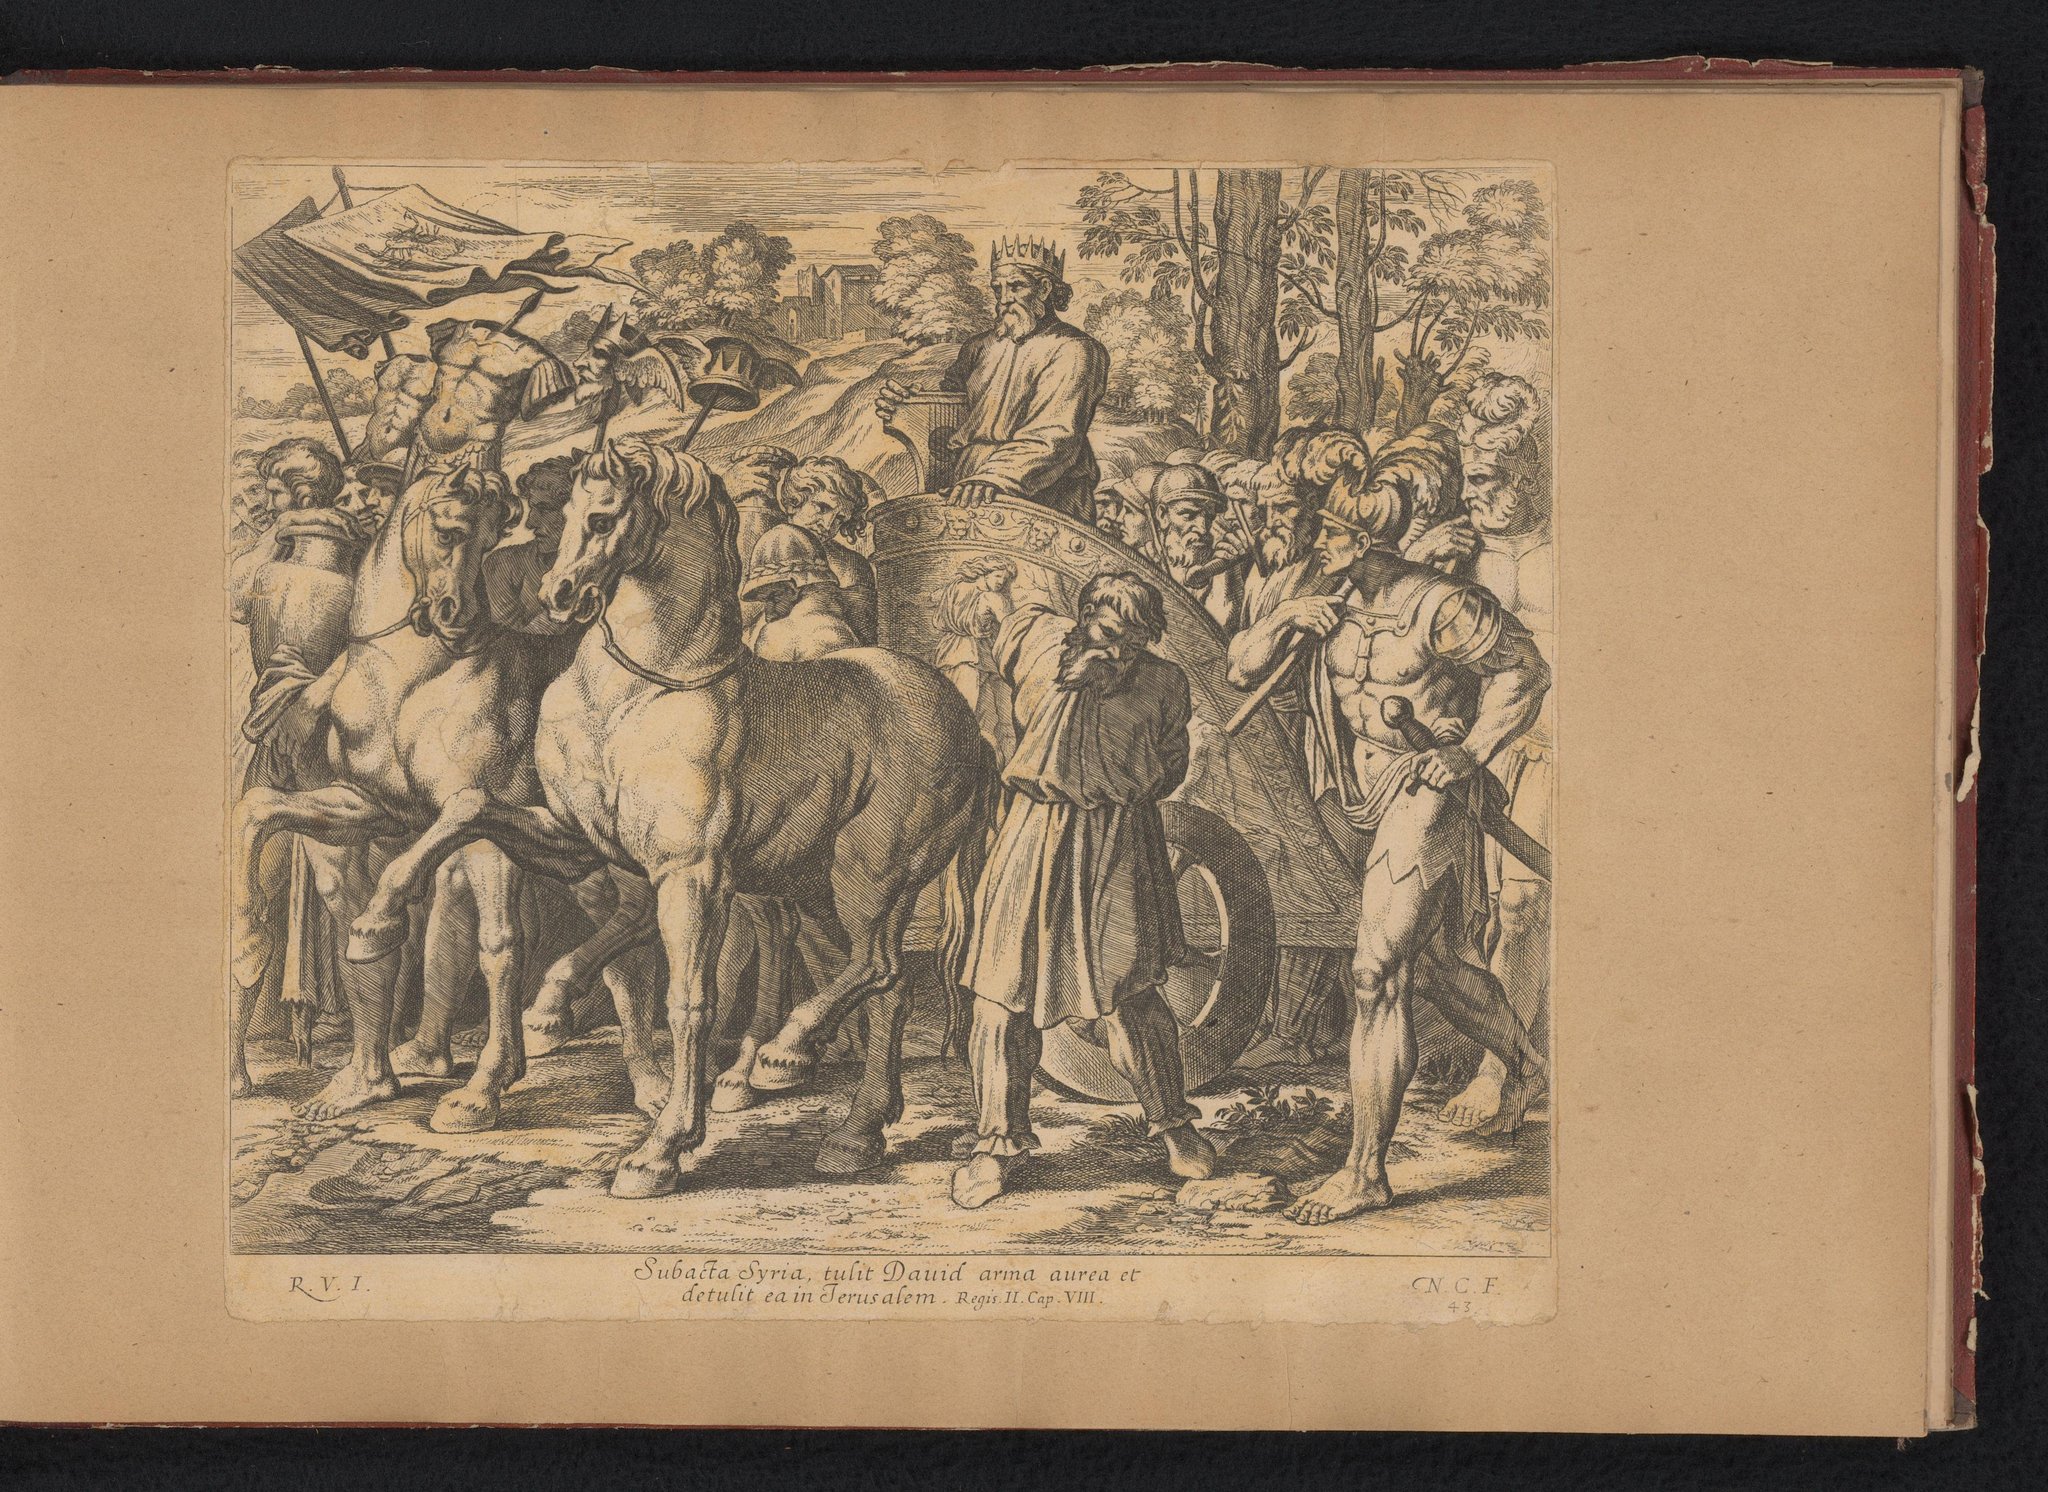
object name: album leaf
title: David onthoofdt Goliat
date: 1649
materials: paper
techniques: etching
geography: paris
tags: david beheads goliath with a sword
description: Deze prent maakt deel uit van een album.